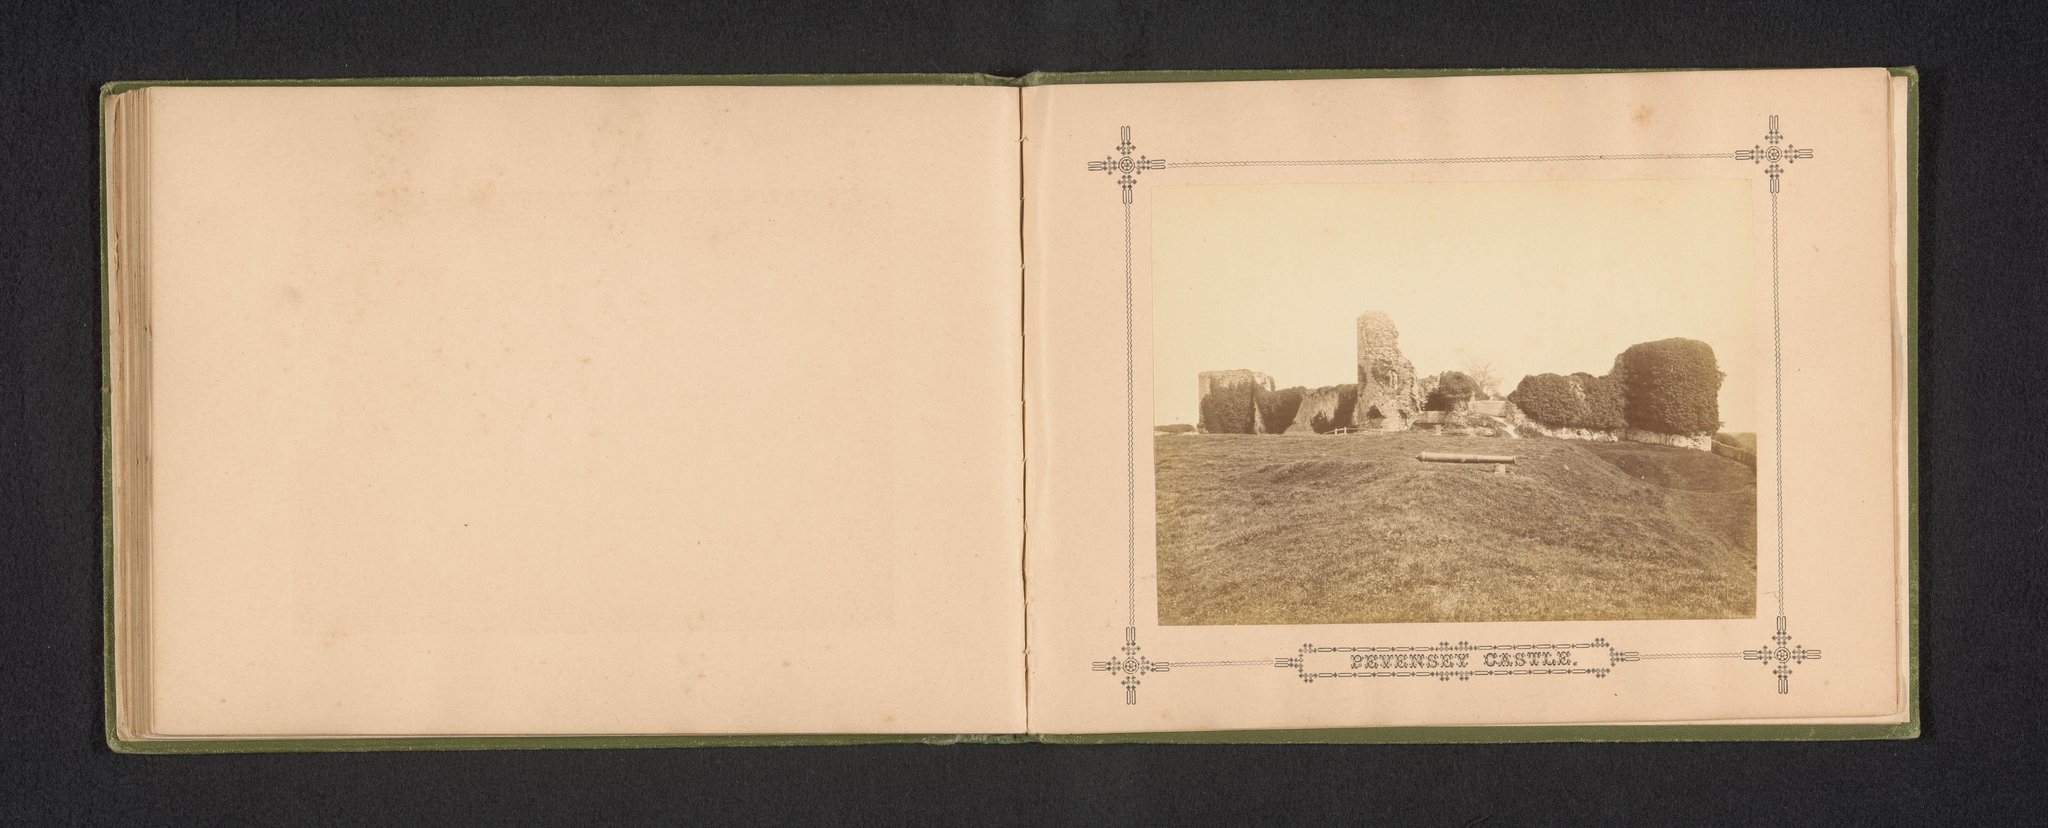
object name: page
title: Bodiam Castle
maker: wm. e. thorpe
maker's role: fotograaf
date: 1870-1875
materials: photographic support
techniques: albumen print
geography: pevensey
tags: castle